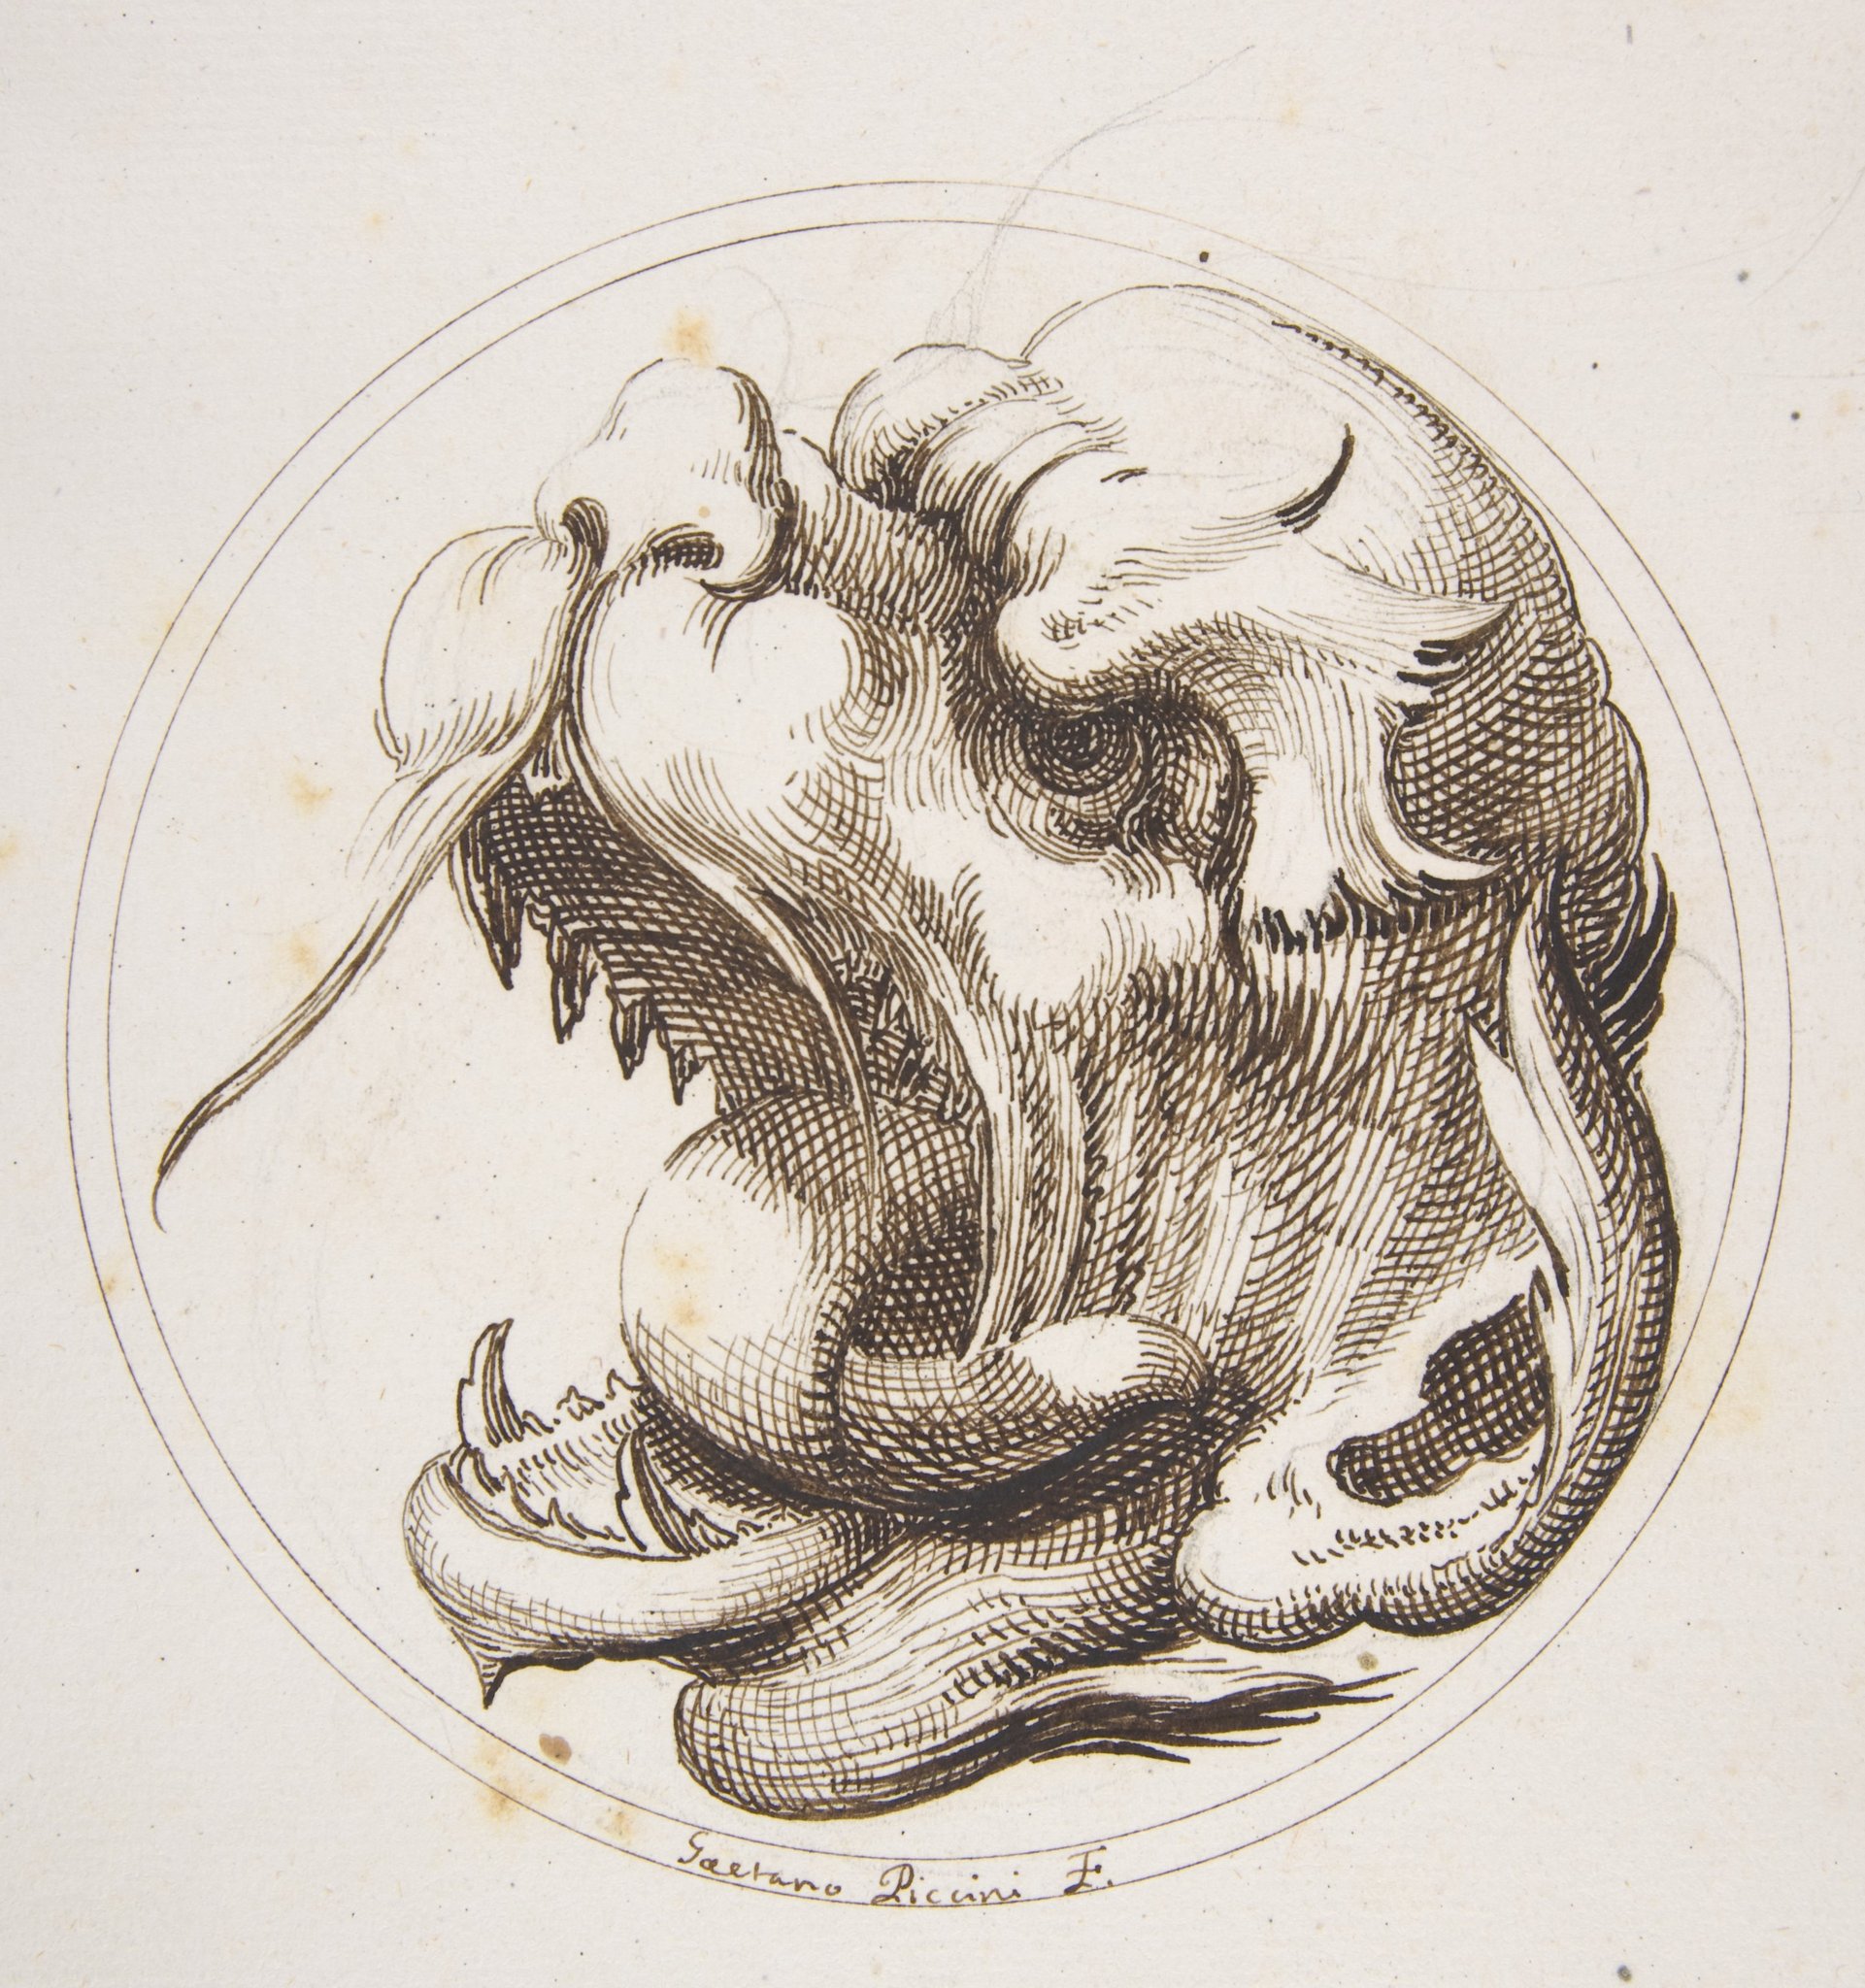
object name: drawing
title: Large Grotesque Head With an Open Mouth Looking to the Left Within a Frame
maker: gaetano piccini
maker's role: artist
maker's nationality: italian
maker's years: 1710-1730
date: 1727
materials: ink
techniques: pen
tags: heads